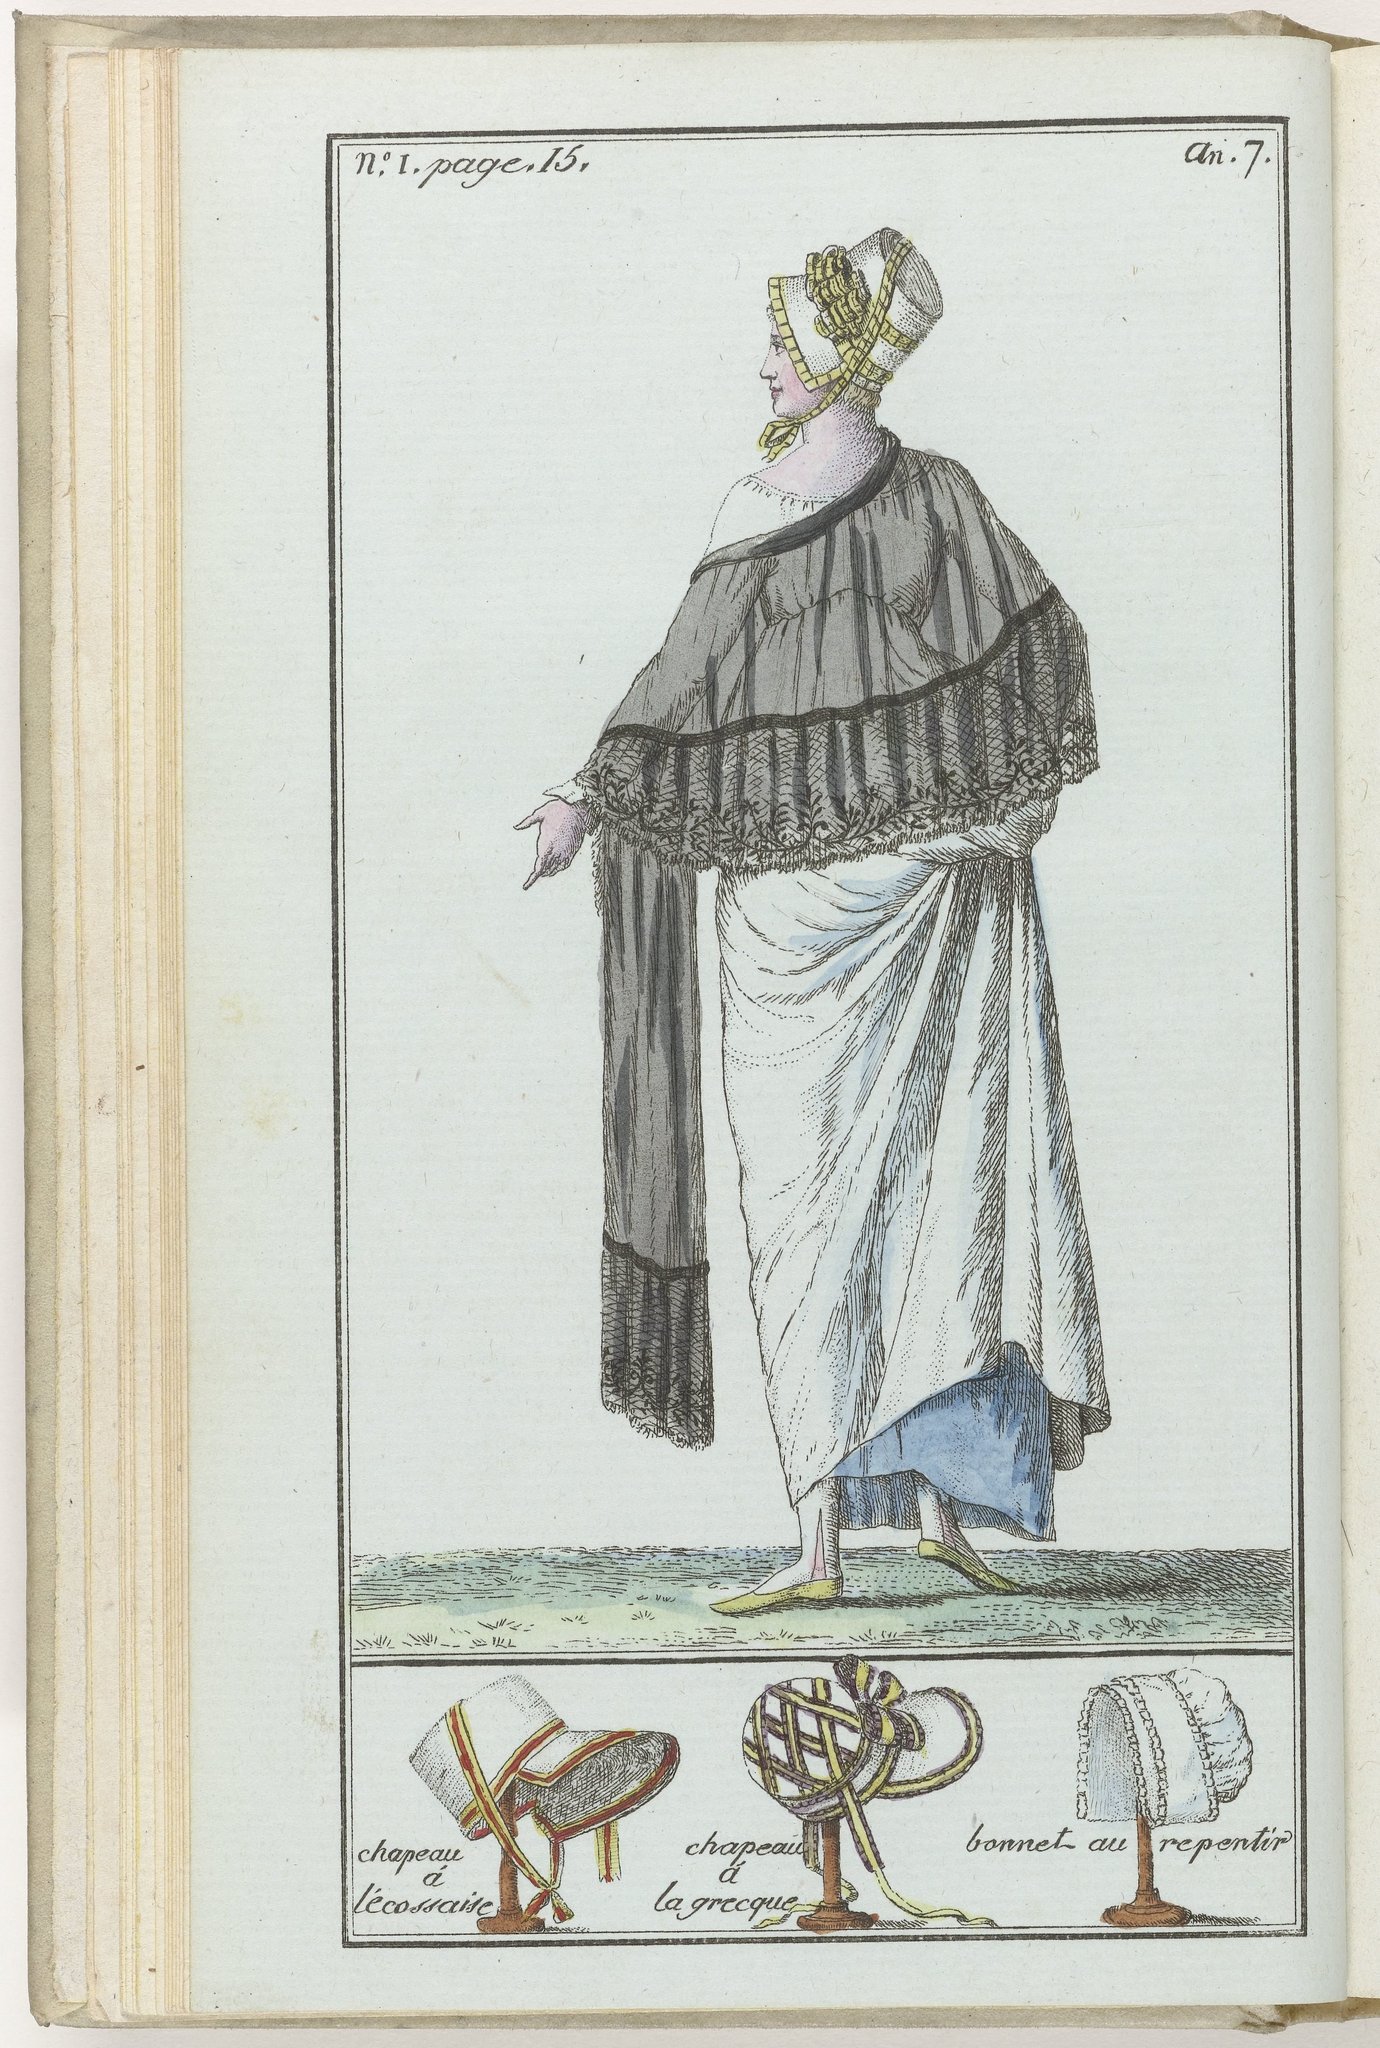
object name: fashion print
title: Le Mois, Journal historique, littéraire et critique, avec figures, Tome 1, No. 1, page 15, An. 7 (1799): Chapeau à l'écossaise...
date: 1799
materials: paper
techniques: etching, hand coloring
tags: clothing for the upper part of the body (shawl) (+ women's clothes), underclothes for the lower part of the body (underskirt) (+ women's clothes), head-gear (straw hat) (+ women's clothes), head-gear: cap (+ women's clothes), fashion plates, shoes, sandals (+ women's clothes), dress, gown (+ women's clothes), stockings, socks (+ women's clothes)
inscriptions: inscription: ‘Chapeau á l'ecossaise / chapeau á la grecque / bonnet au repentir’, inscription: ‘No. 1, page. 15. / An. 7.’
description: Vrouw, op de rug gezien, met op het hoofd een witte strohoed versierd met linten. Zij draagt een witte japon met lange mouwen op een blauwe onderrok. Om de schouders een lange en grote sjaal van effen mousseline. Volgens de begeleidende tekst in het tijdschrift (p. 15,16 en 17) is een nieuwste versie van Italiaanse tafzijde te koop bij Le Normand, rue Honoré. Onderaan in een kader twee hoeden en een muts op hoedenstandaards: v.l.n.r.: 'Chapeau a l'écossaise, Chapeau a la grecque, Bonnet au repentir'. Prent uit het tijdschrift Le Mois : Journal historique, littéraire et critique avec figures, An 7 en 8 (1799-1800). De prent is een gespiegeld (en iets gewijzigde) kopie naar 19 avril 1799, An 7 (102) uit het modetijdschrft Journal des Dames et des Modes (1797-1839).